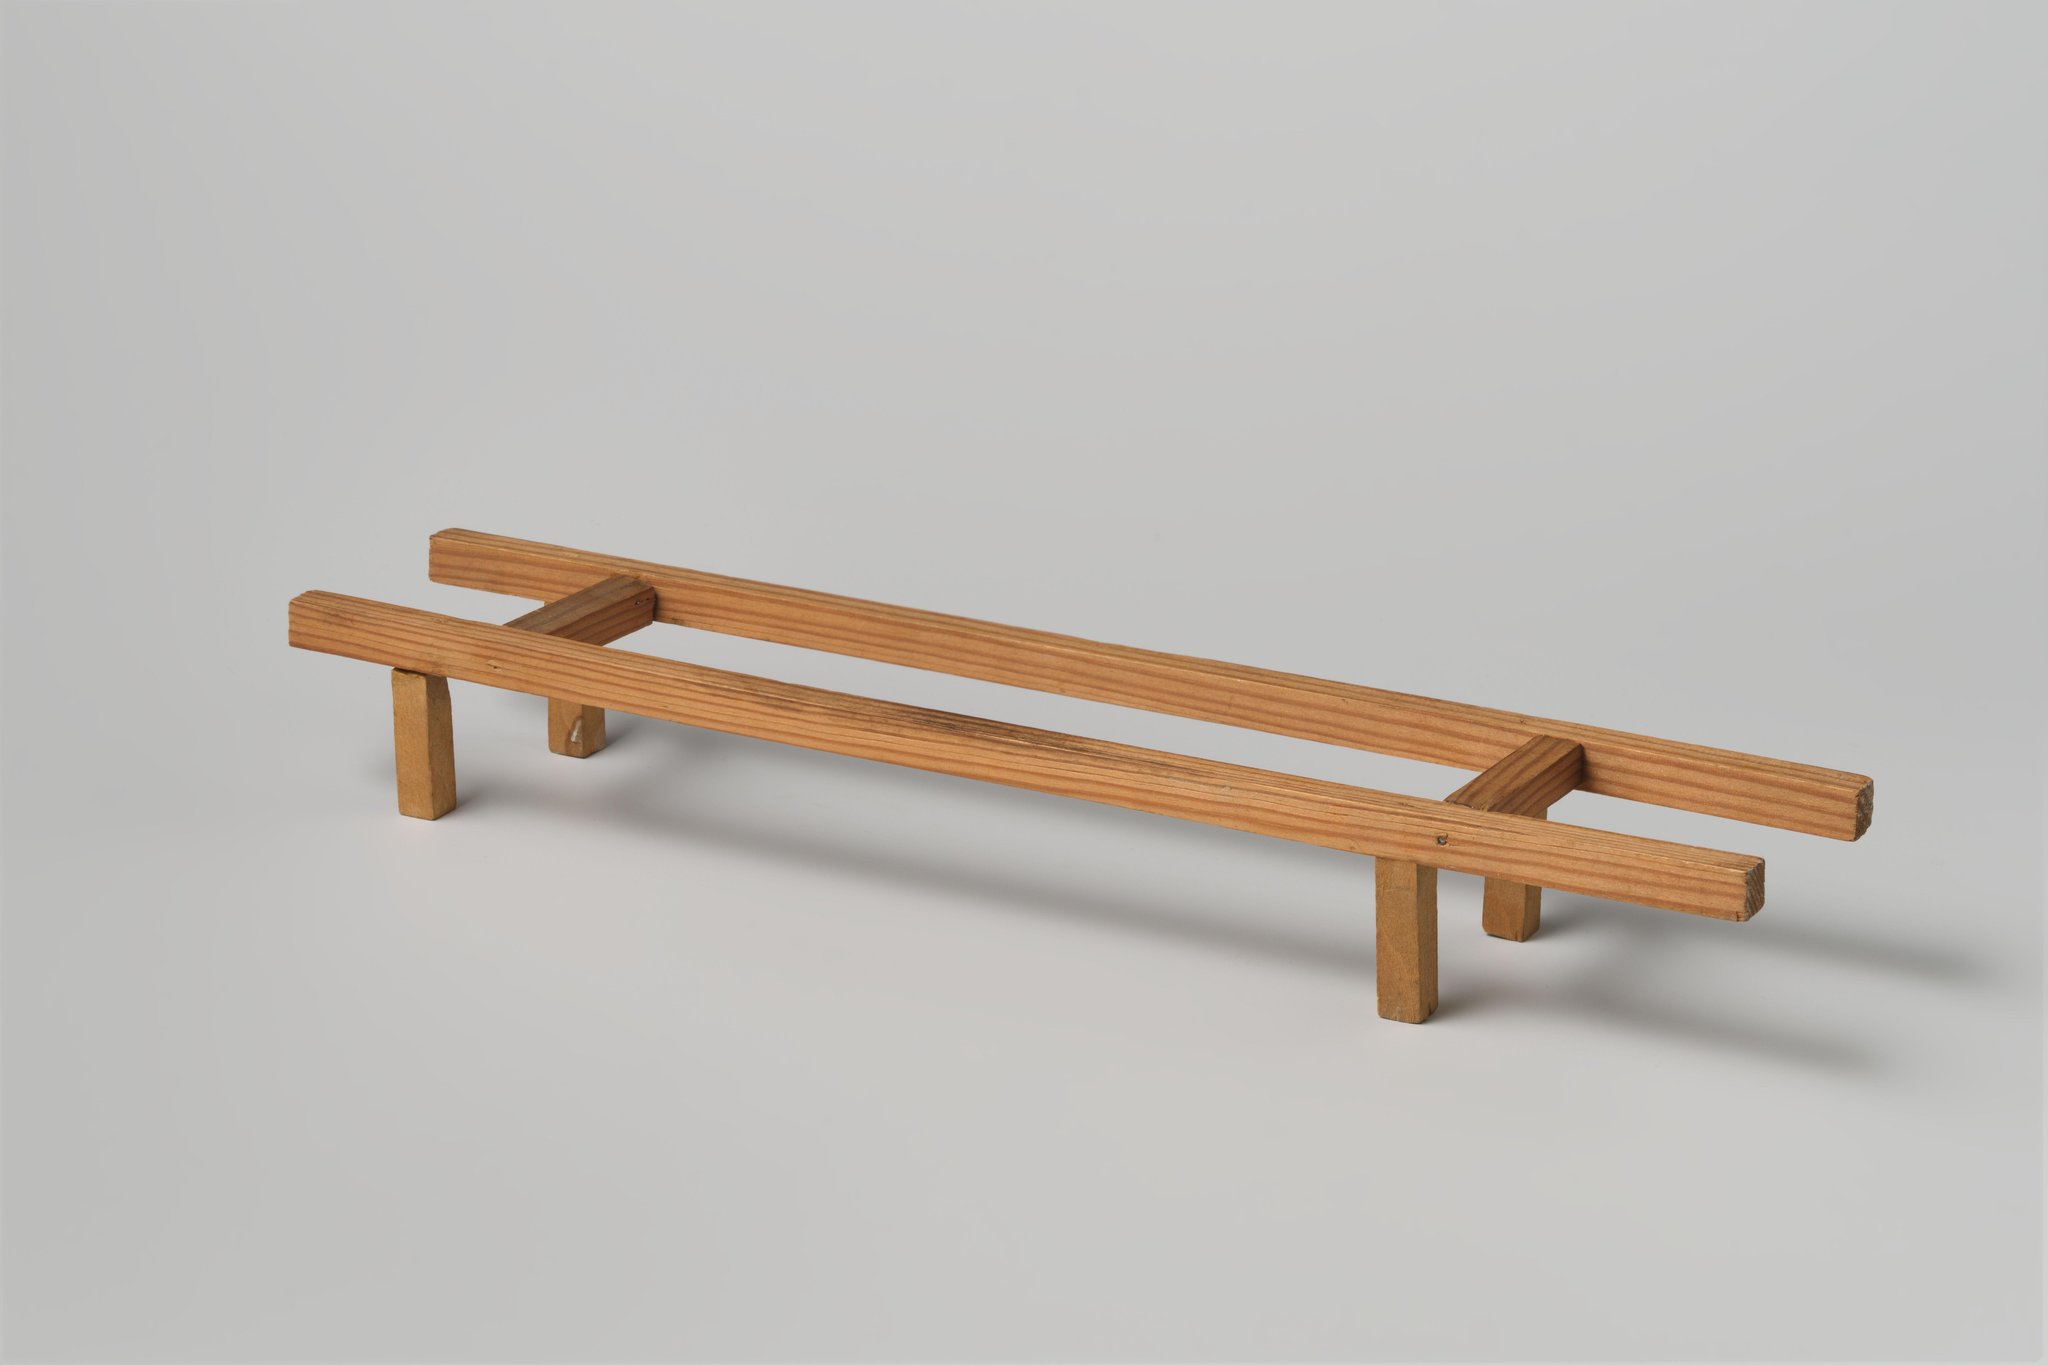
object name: gantry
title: Stelling voor vaten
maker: Anonymous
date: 1676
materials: wood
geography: amsterdam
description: Stelling voor vaten, vervaardigd uit twee lange horizontale leggers van grenenhout, twee dwarsregels en rustend op vier poten van lindehout. De verbindingen met metalen nagels.